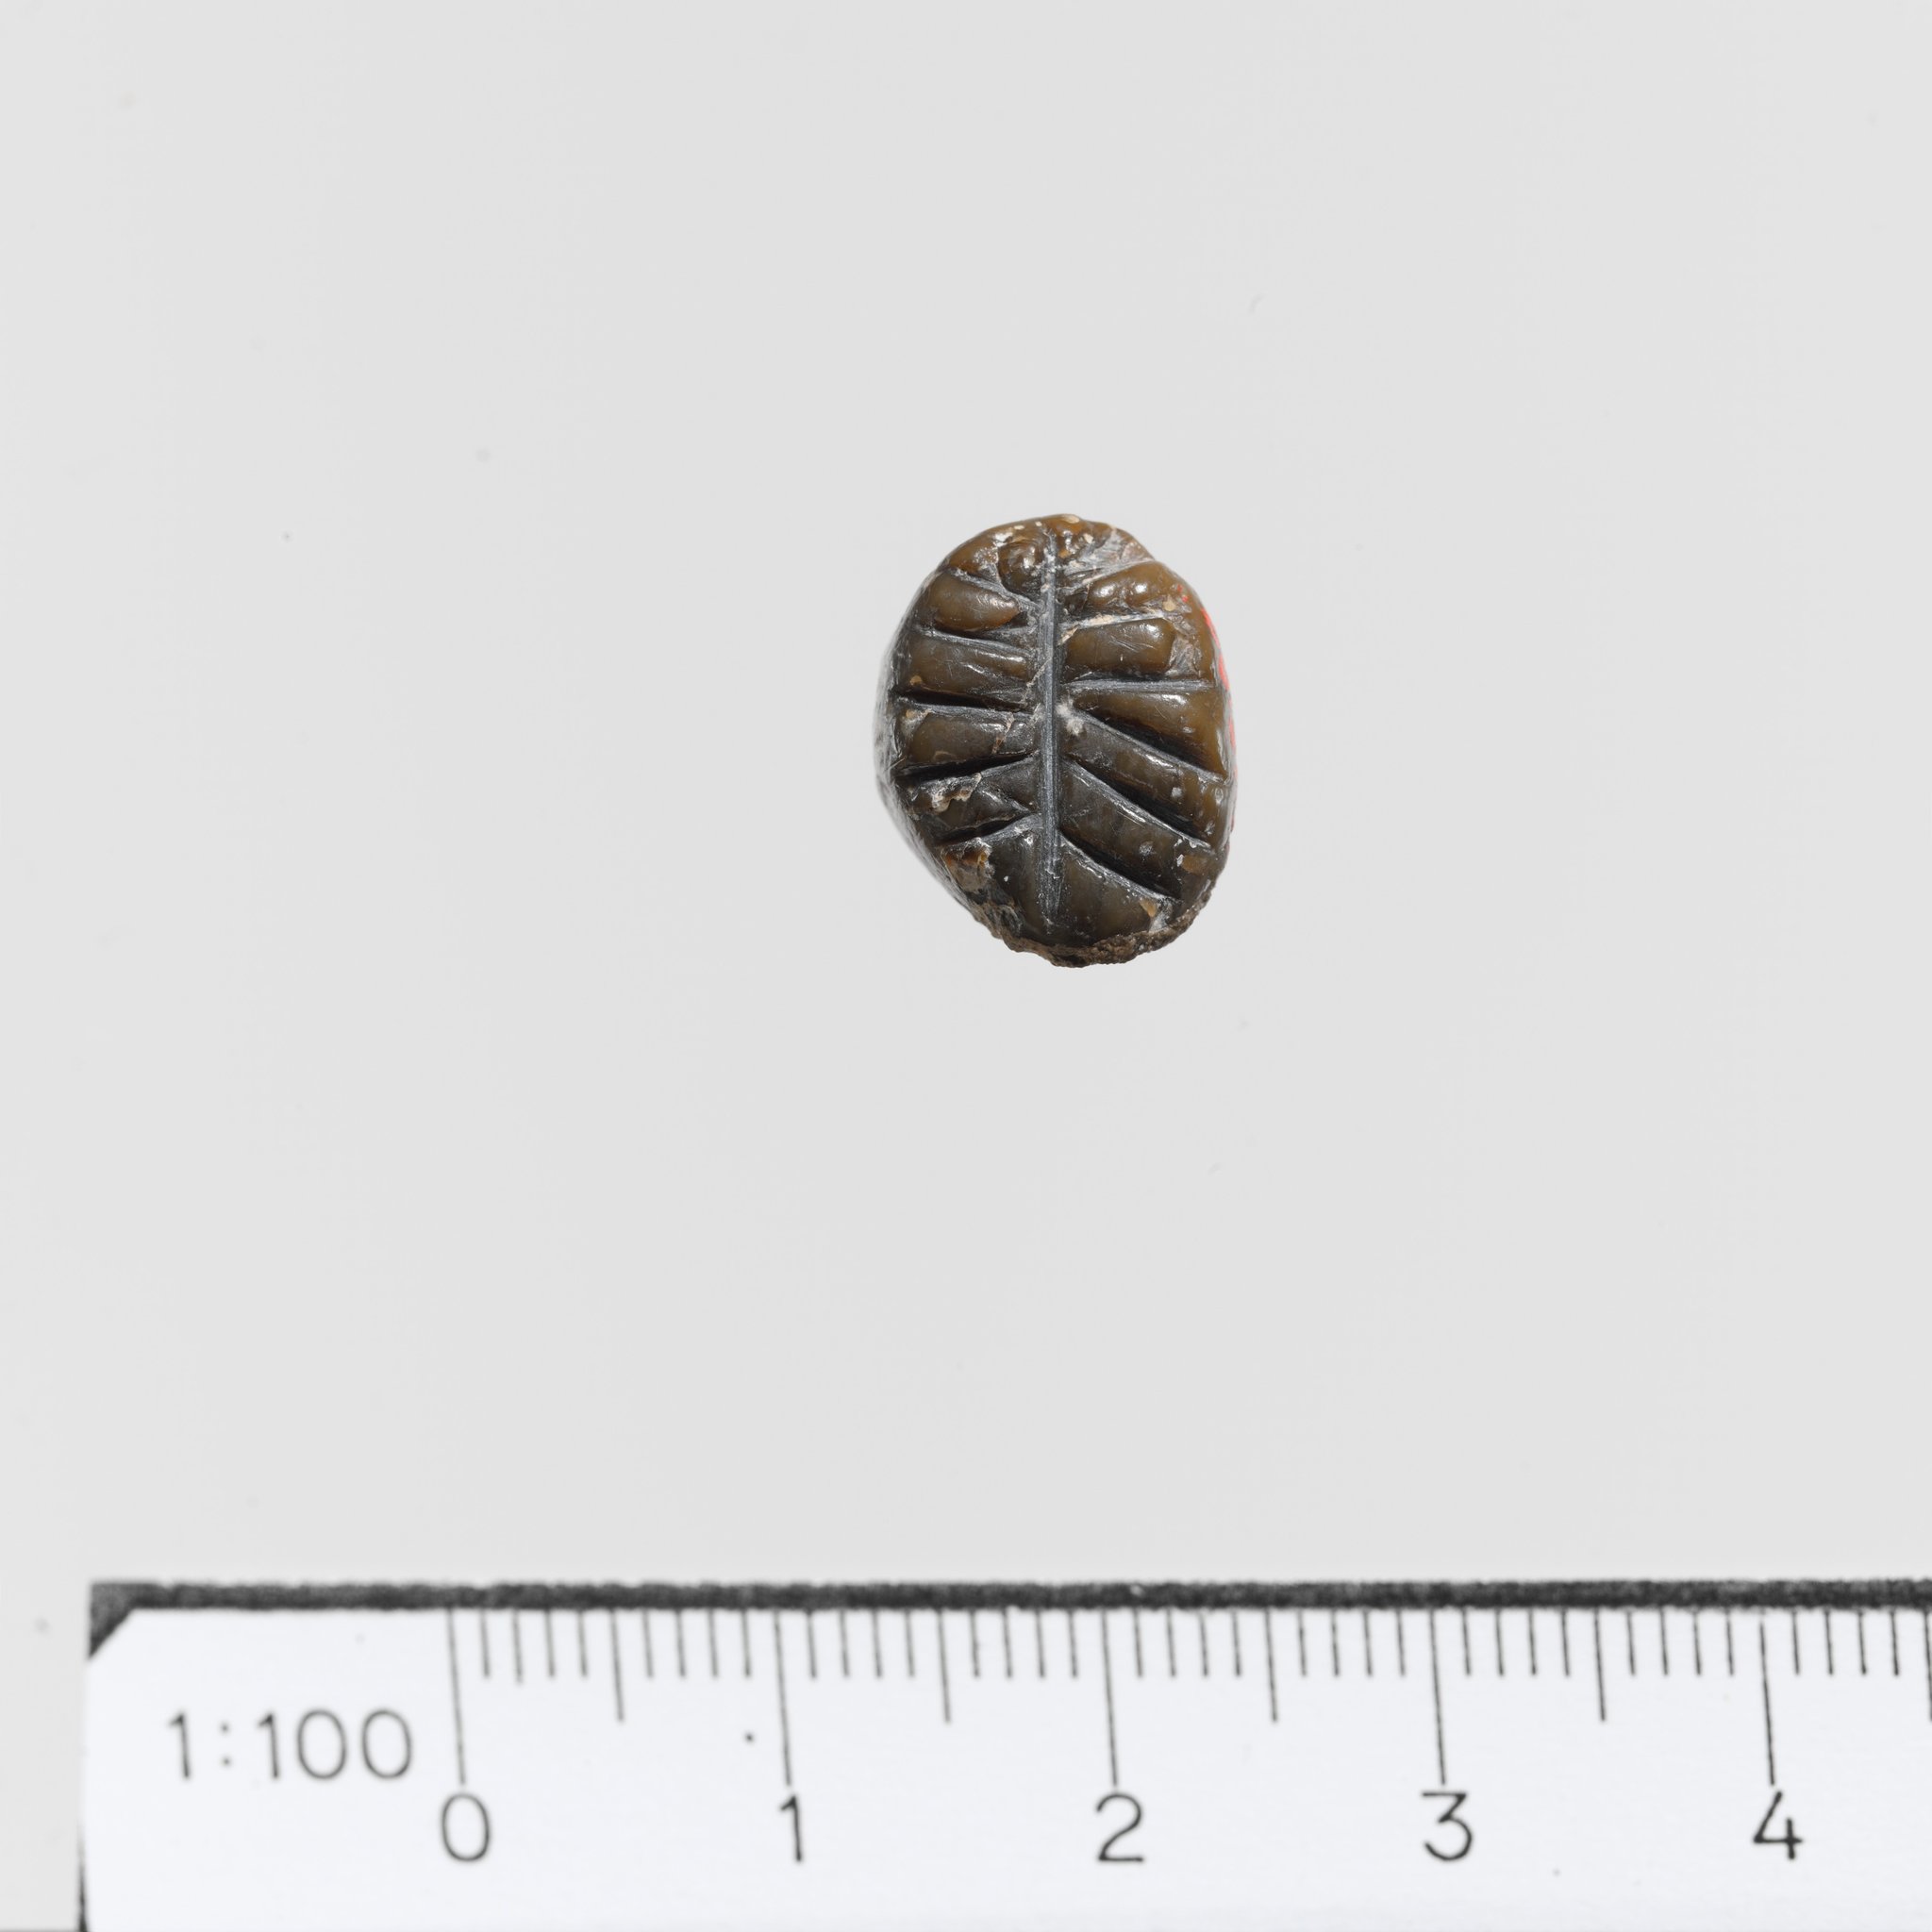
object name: stamp seal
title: Seal stamp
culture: minoan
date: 2200-1900 BCE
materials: stone